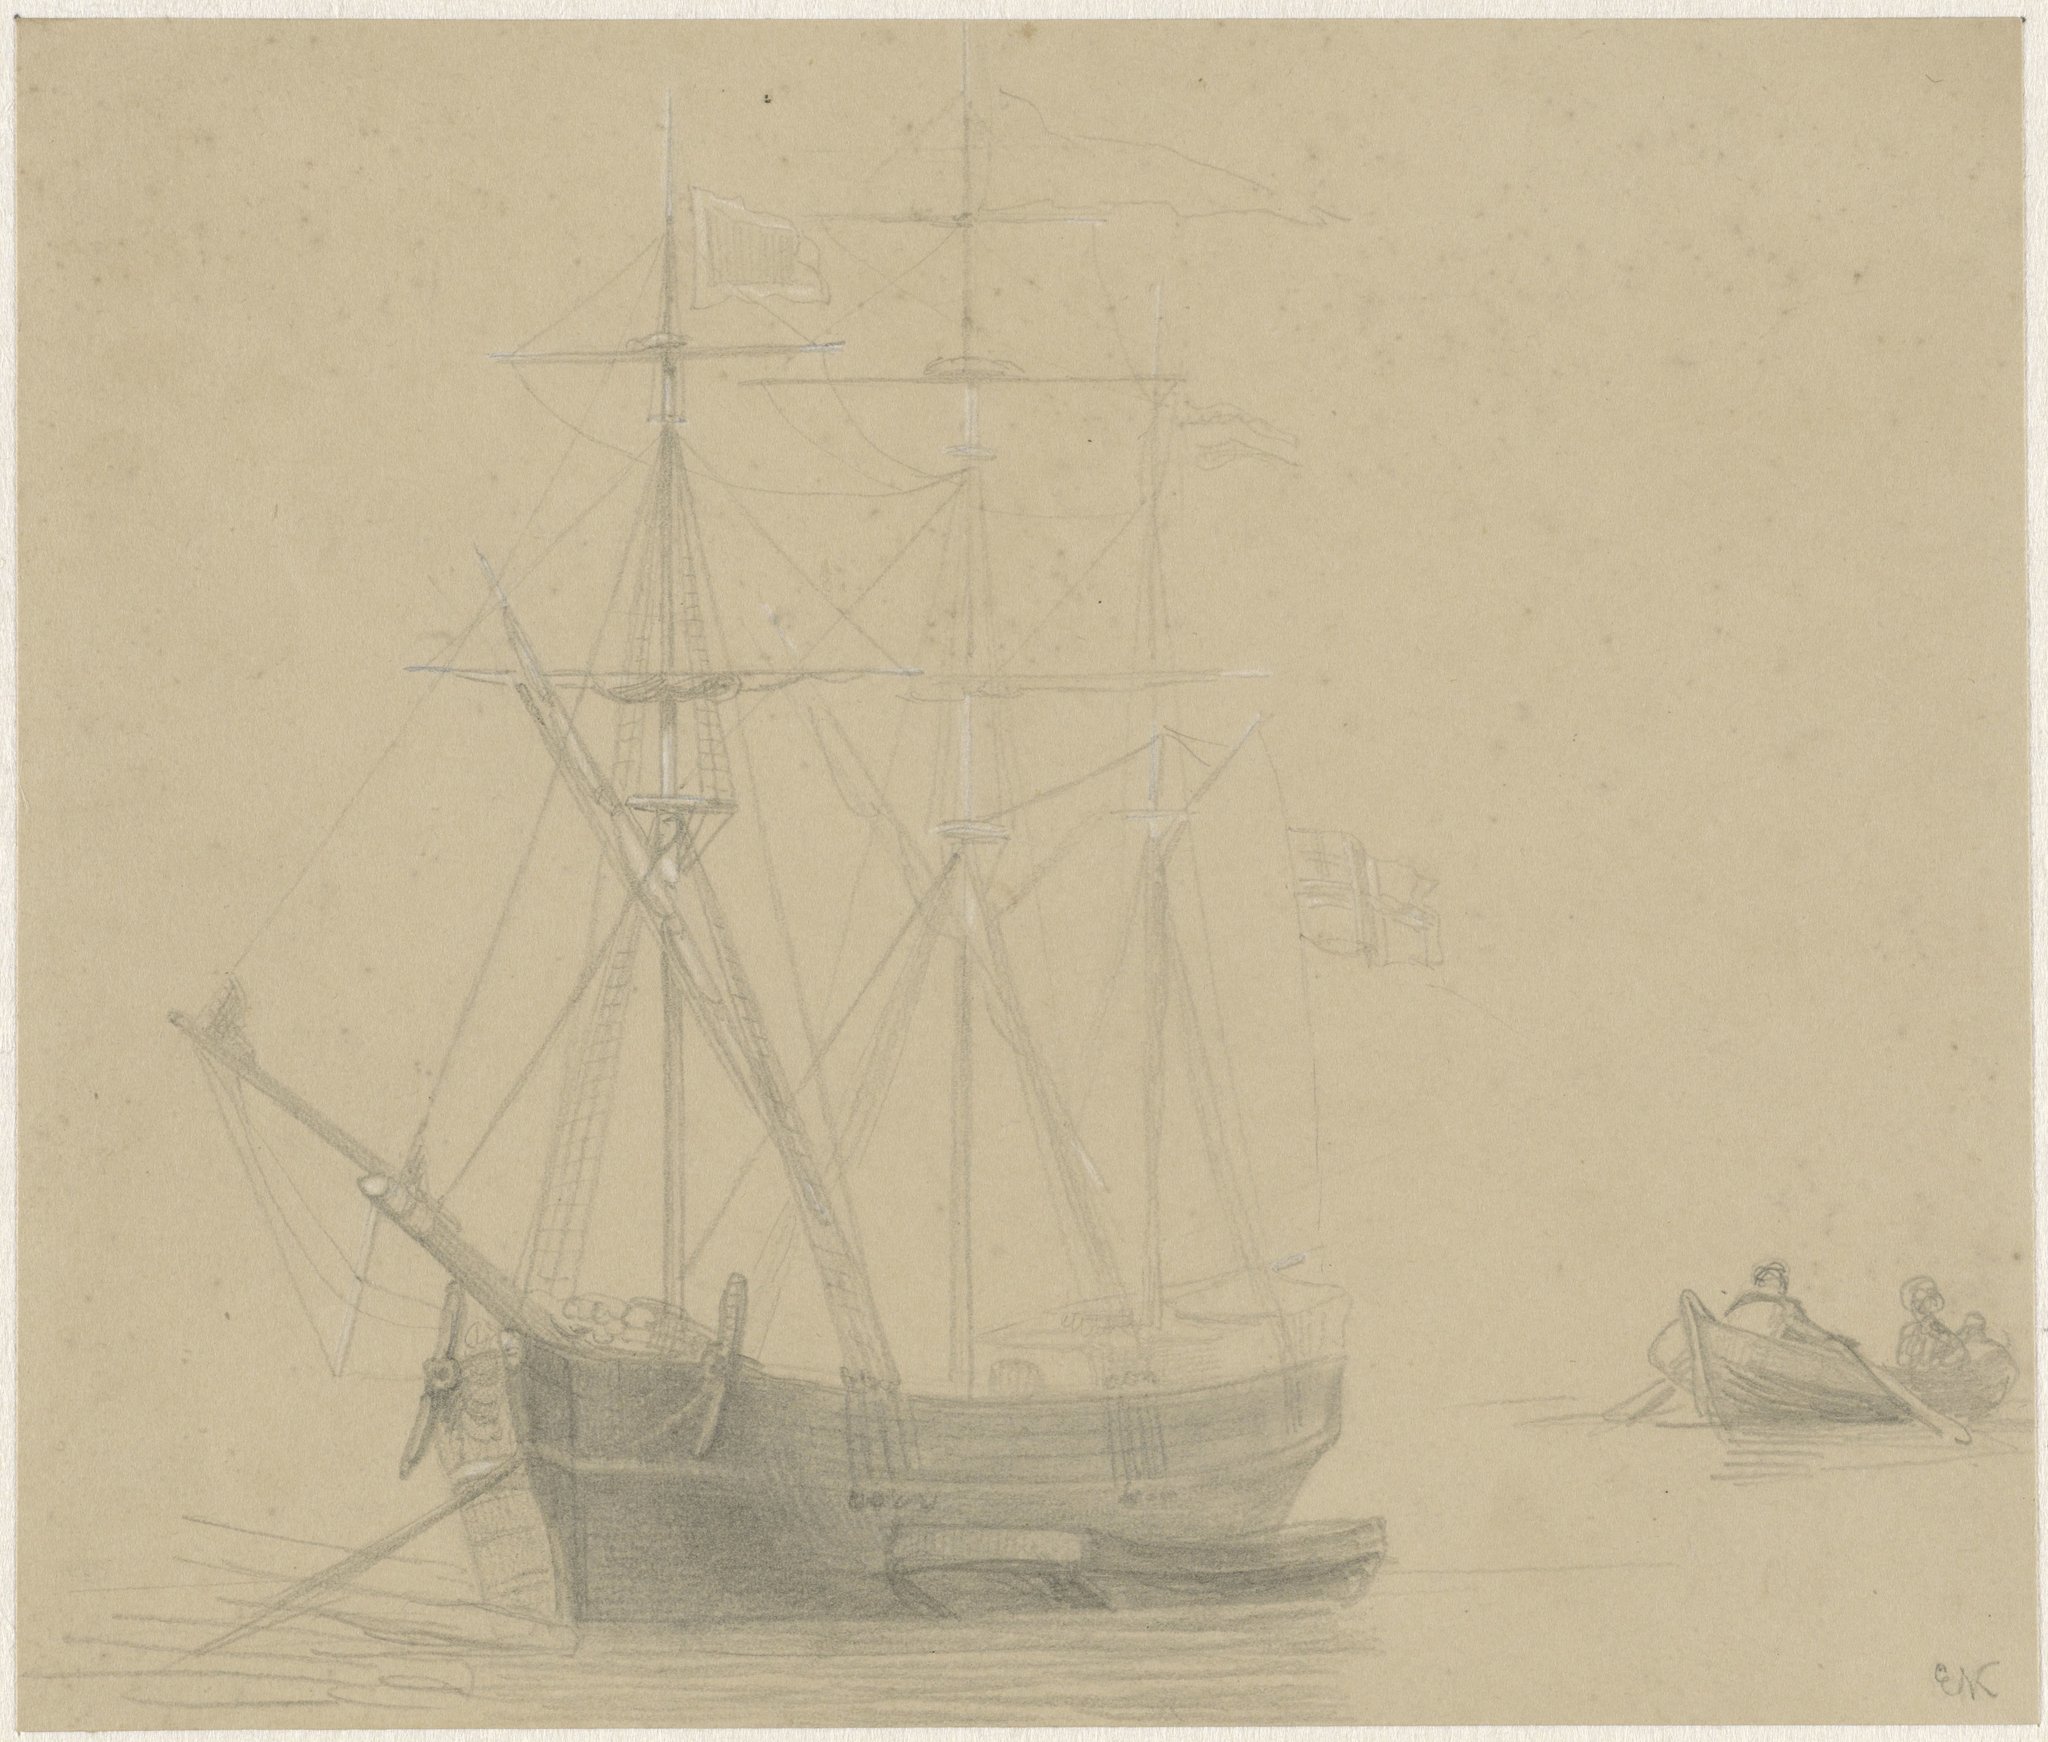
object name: drawing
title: Driemaster en sloep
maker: everhardus koster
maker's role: draughtsman, painter, print maker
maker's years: 1817-1892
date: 1827-1892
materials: chalk, paper, pencil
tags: sailing-ship, sailing-boat, rowing-boat, canoe, etc.